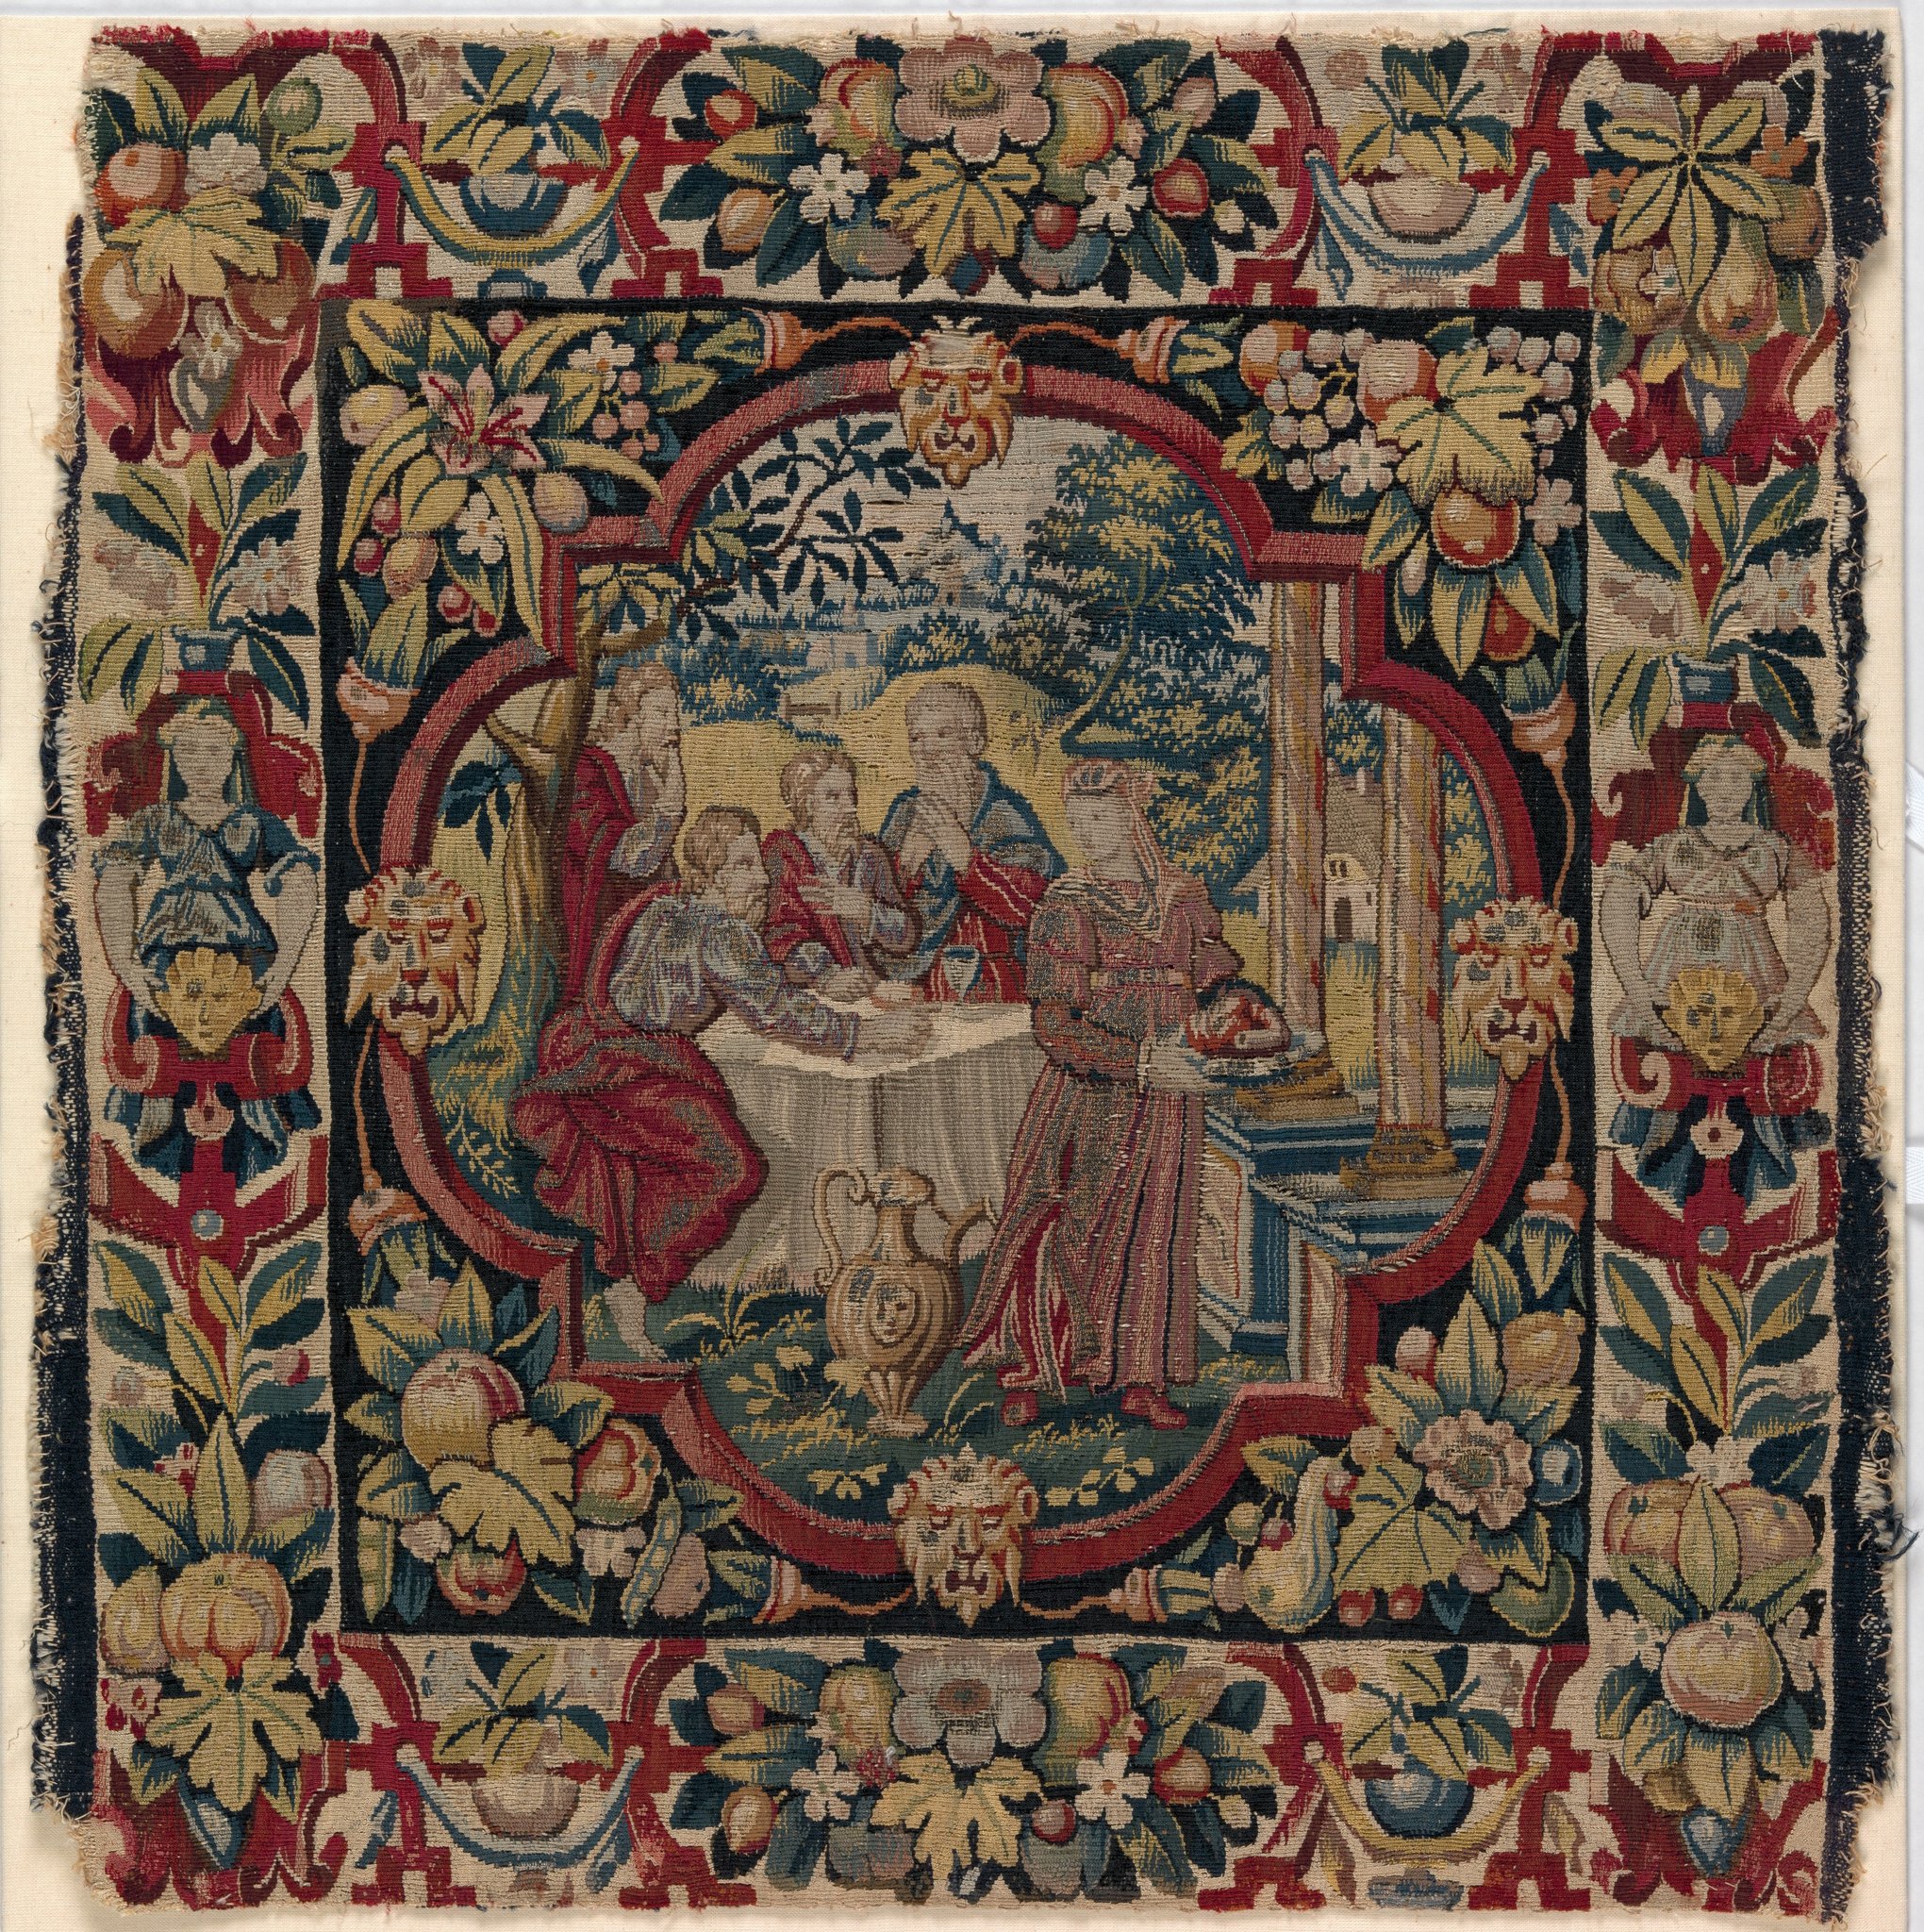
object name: cushion cover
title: Abraham Entertaining the Angels from the Story of Abraham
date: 1600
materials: silk, silver gilt, thread, wool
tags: human figures,fruit,flowers,angels,abraham